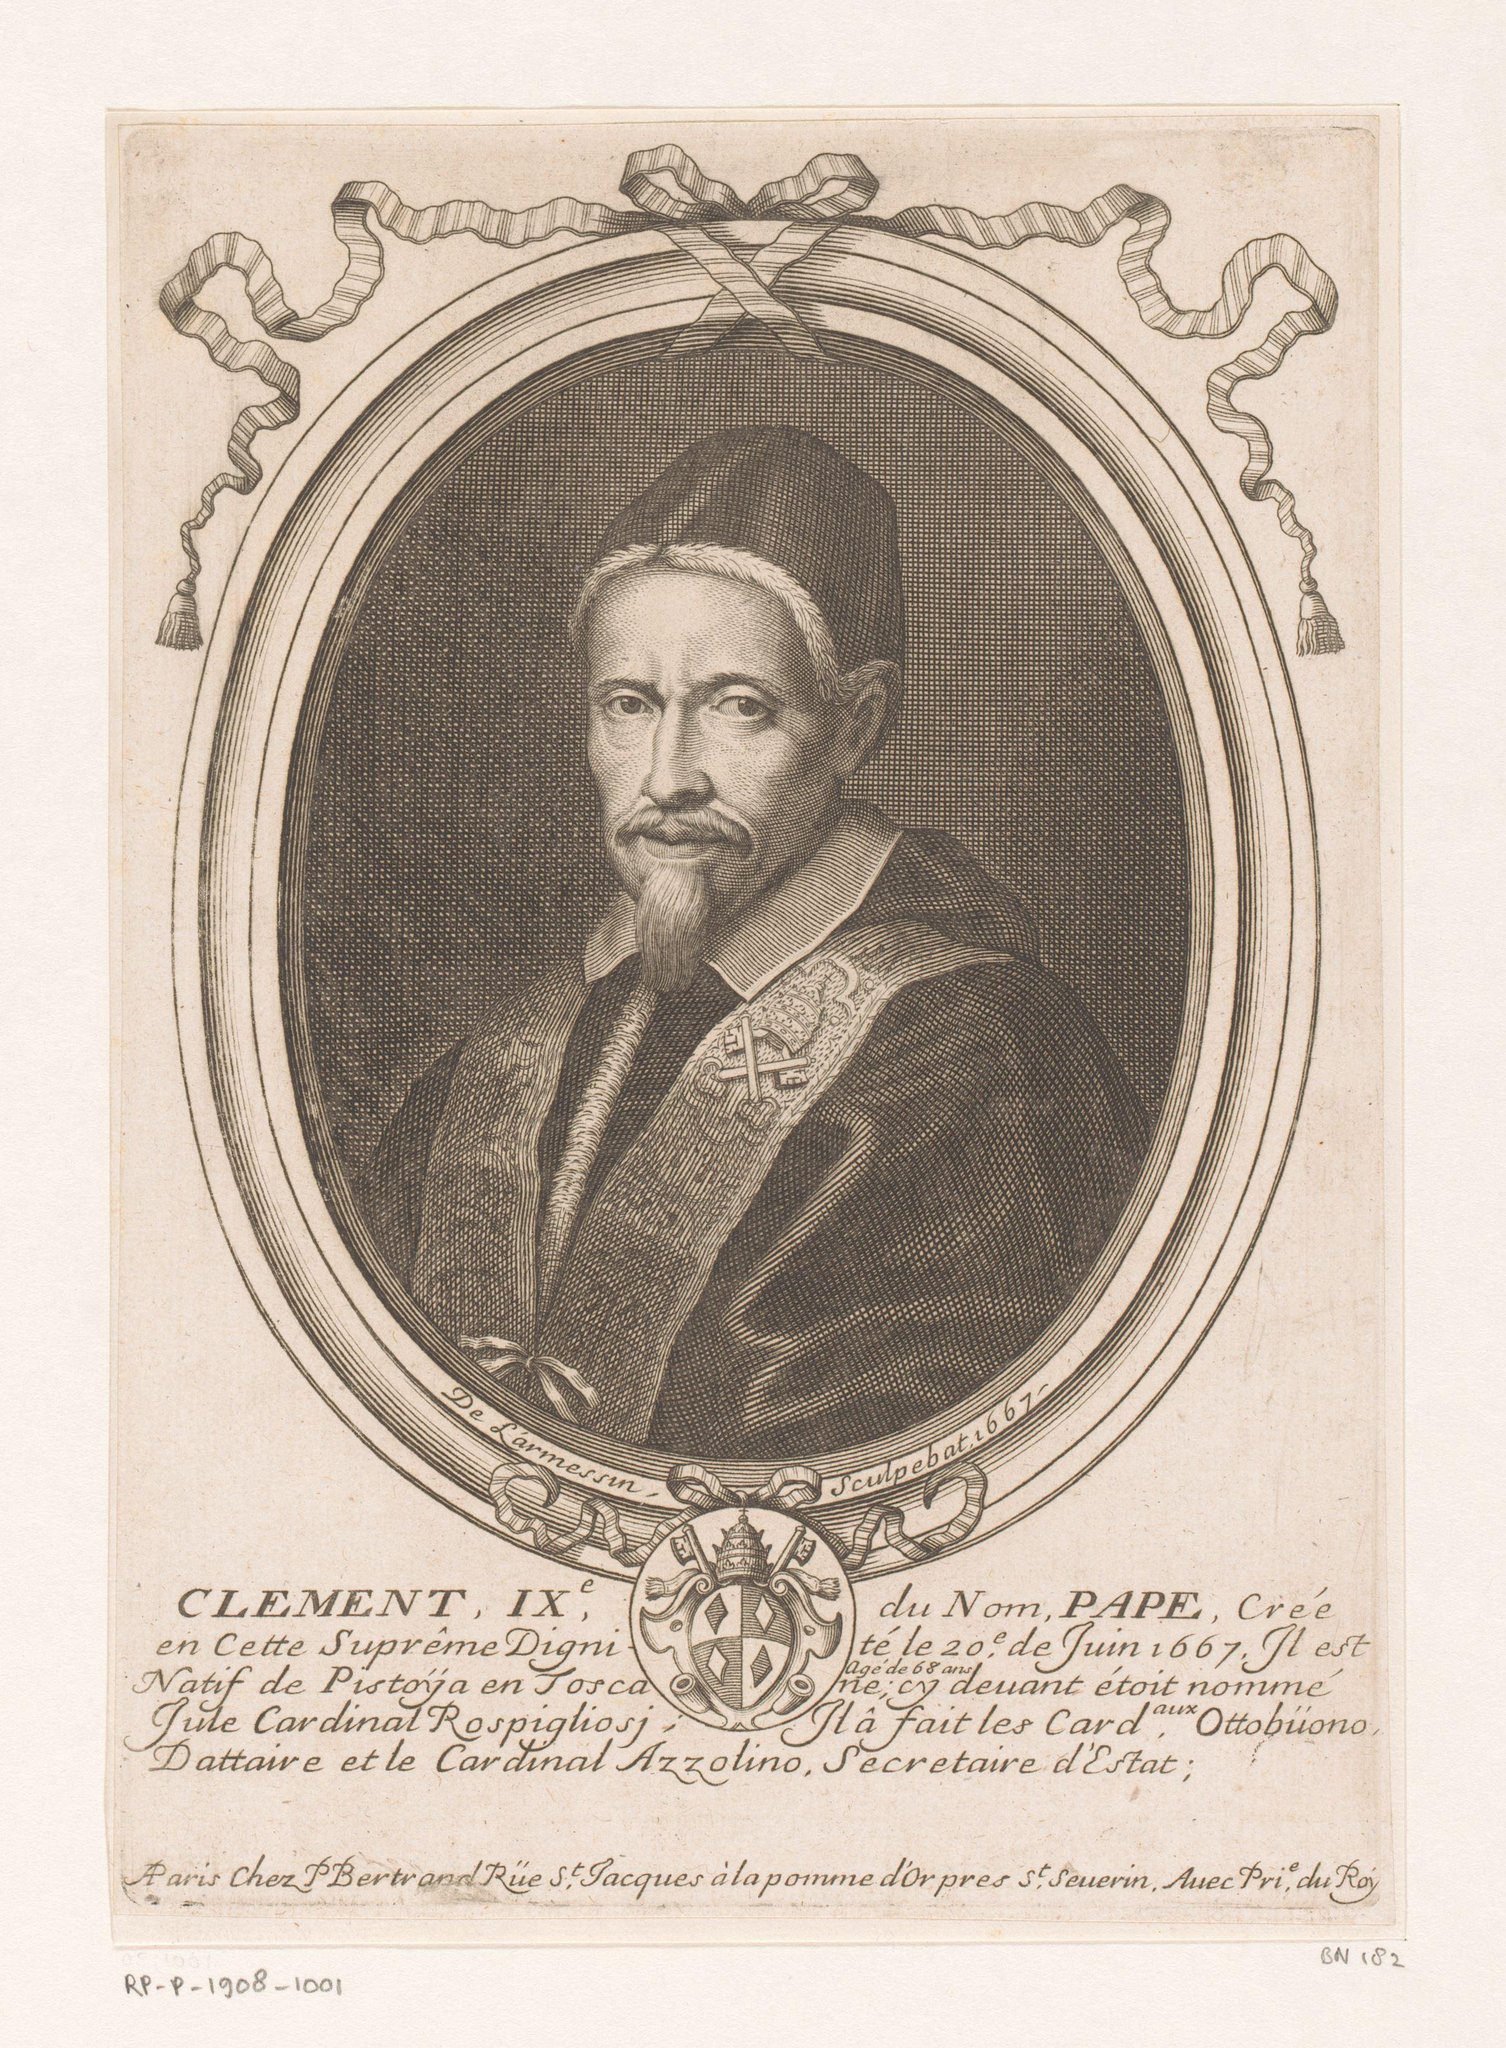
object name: print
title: Portretten van prominente figuren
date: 1667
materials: paper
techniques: engraving, etching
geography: paris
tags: clemens ix, historical persons, pope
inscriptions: collector's mark: Lugt 2228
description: Maakt deel uit van een grootschalige serie met portretten van prominente figuren. Binnen de serie bevindt zich een sectie getiteld 'Les Augustes Représentations De tous les Roys De France depuis Pharamond Iusqu'à Louys XIIII'. De serie werd respectievelijk uitgegeven door Pierre Bertrand, door zijn weduwe en door De Larmessin zelf.